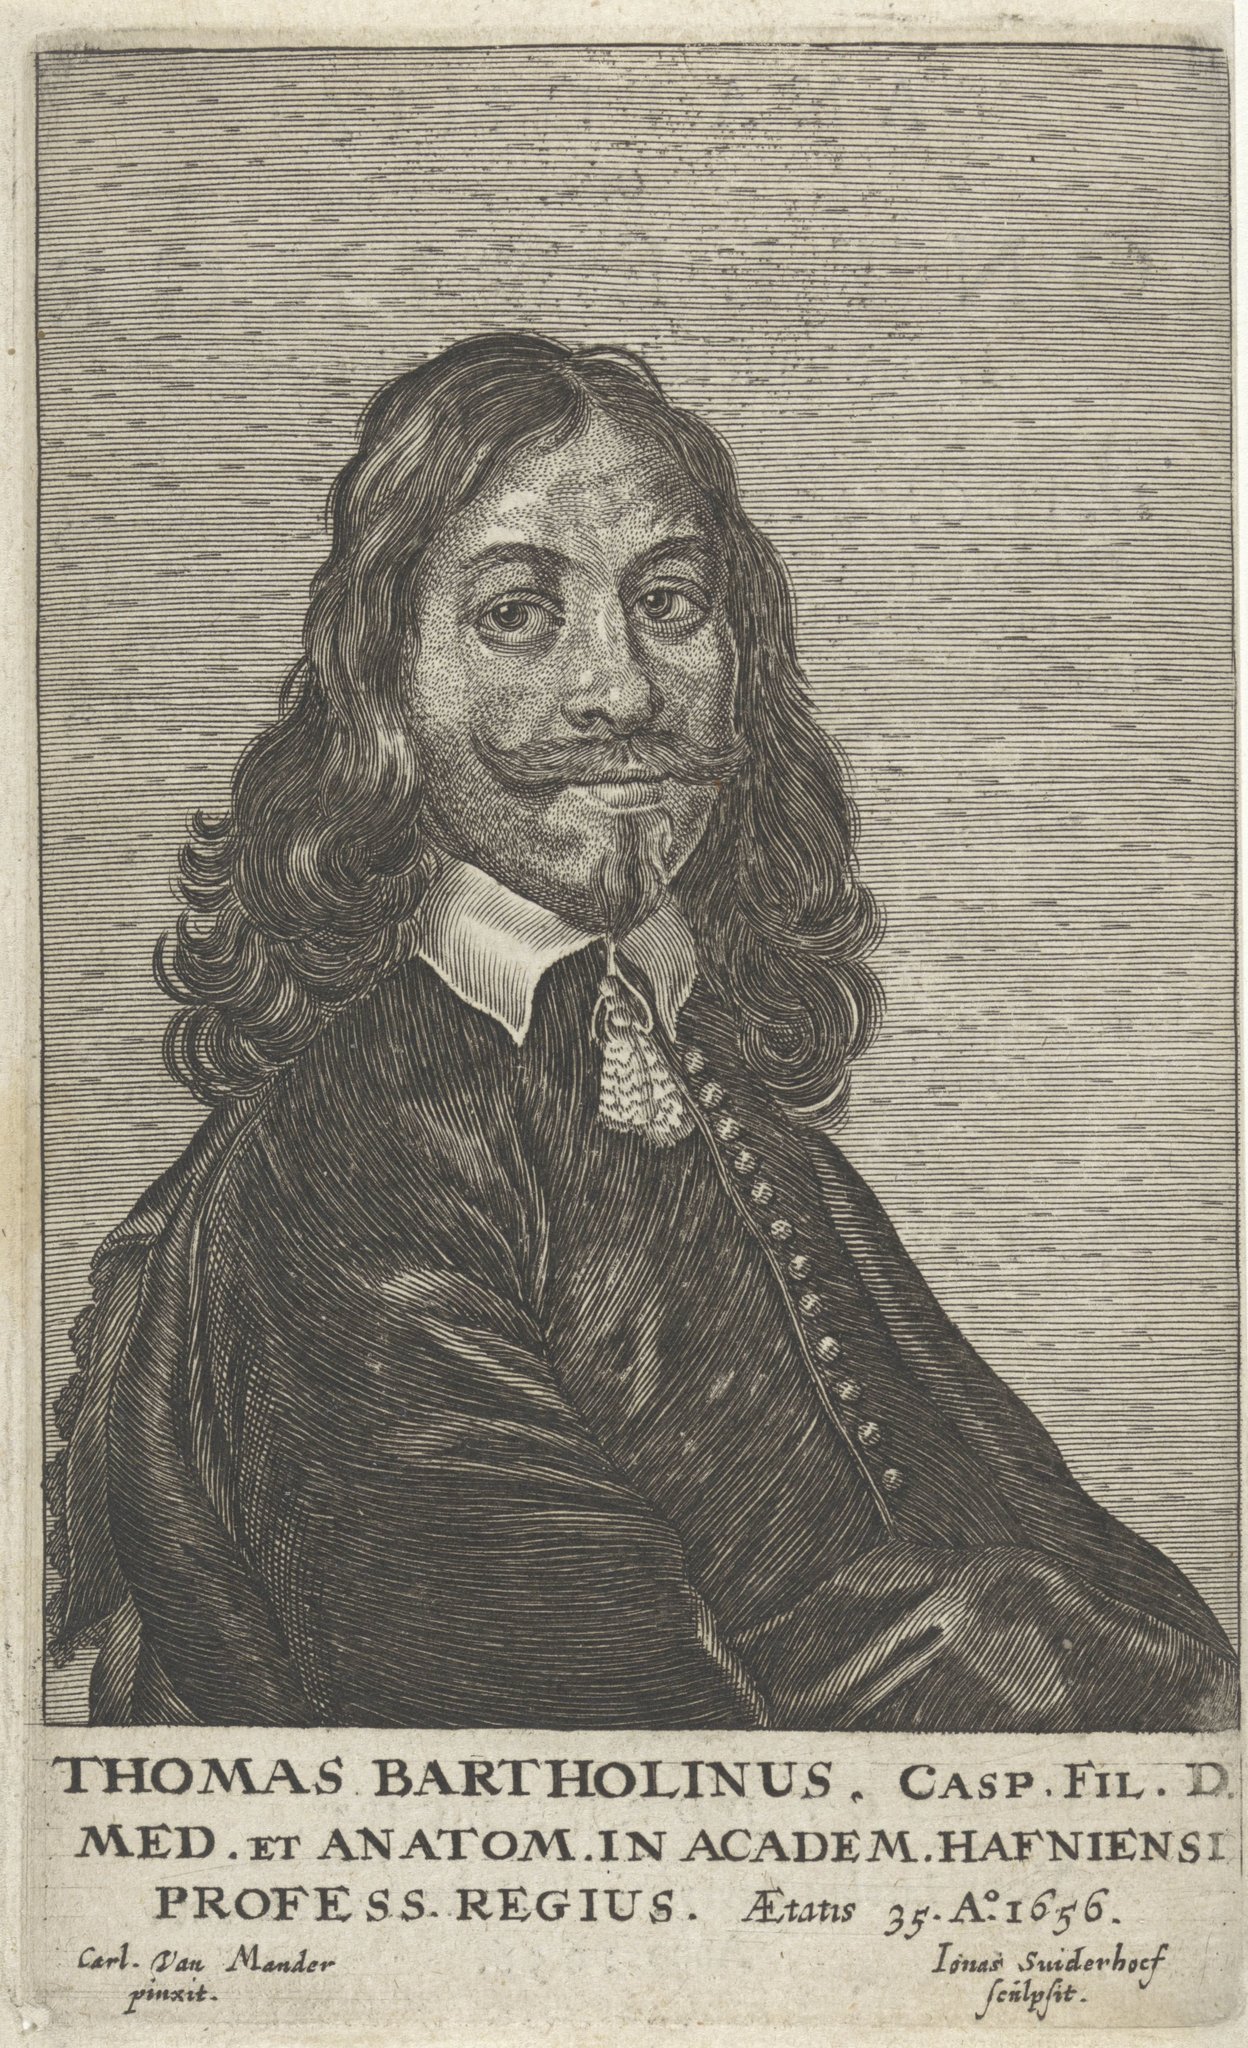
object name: print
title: Portret van Thomas Bartholinus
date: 1656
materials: paper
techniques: engraving, letterpress printing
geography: haarlem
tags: copenhagen (city), thomas bartholin, physician, doctor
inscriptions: signature: ‘Carl Van Mander pinxit. Ionas Suiderhoef sculpsit.’, collector's mark: Lugt 2228, caption: ‘THOMAS BARTHOLINUS, Casp. Fil. D. MED. et ANATOM. IN ACADEM. HAFNIENSI PROFESS. REGIUS. Aetatis 35. Ao.1656.’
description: Portret van Thomas Bartholinus, Deens arts en anatoom, op 35-jarige leeftijd. Onderaan in de marge een drieregelige tekst in het Latijn. Verso de titelpagina voor zijn boek Anatomia: ofte, ontledinge des menschelicken lichaems, 1656.